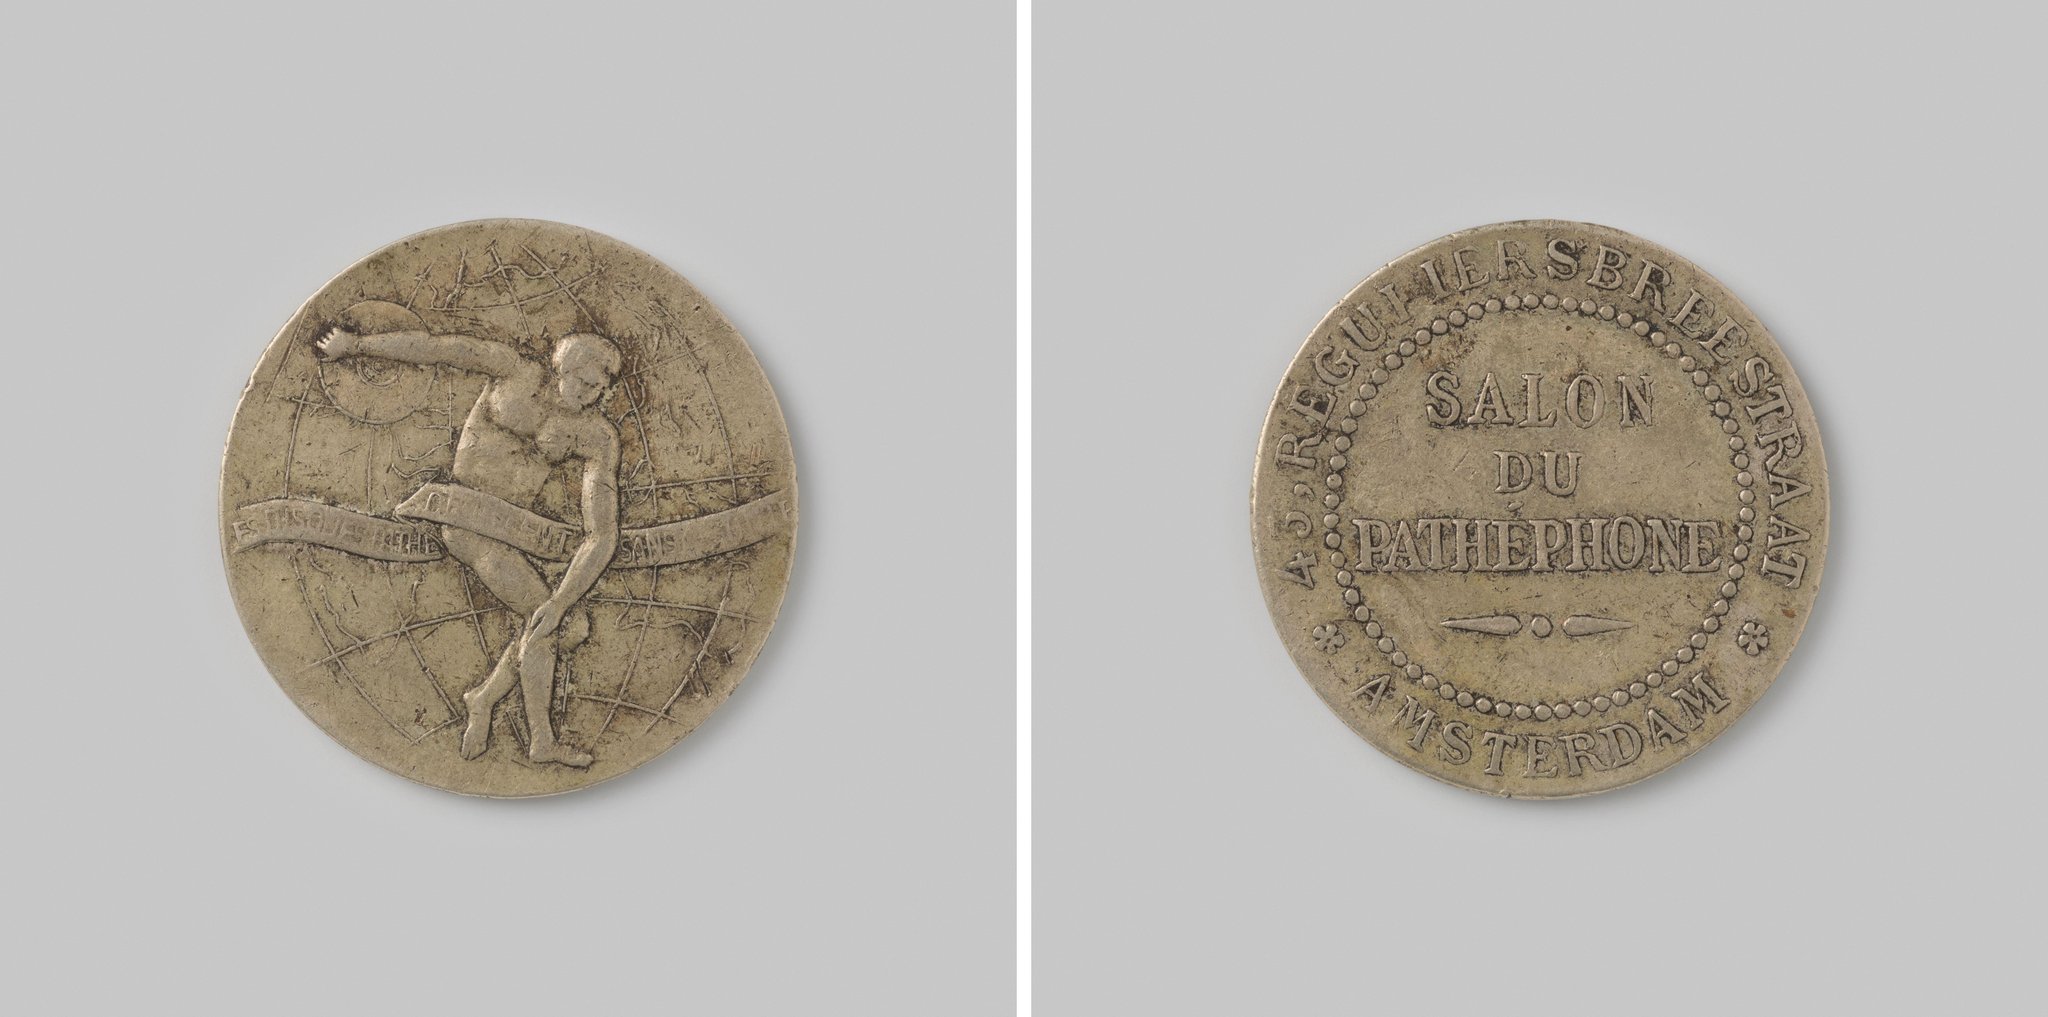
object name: history medal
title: Automaat- of adrespenning van de Salon du Pathéphone te Amsterdam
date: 1900-1930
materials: metal alloy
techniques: striking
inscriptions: circumscription: ‘43 REGULIERSBREESTRAAT / AMSTERDAM’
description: Messing penning, op de voorzijde een discuswerper voor een wereldbol, op de keerzijde de tekst SALON DU PATHÉPHONE met omschrift